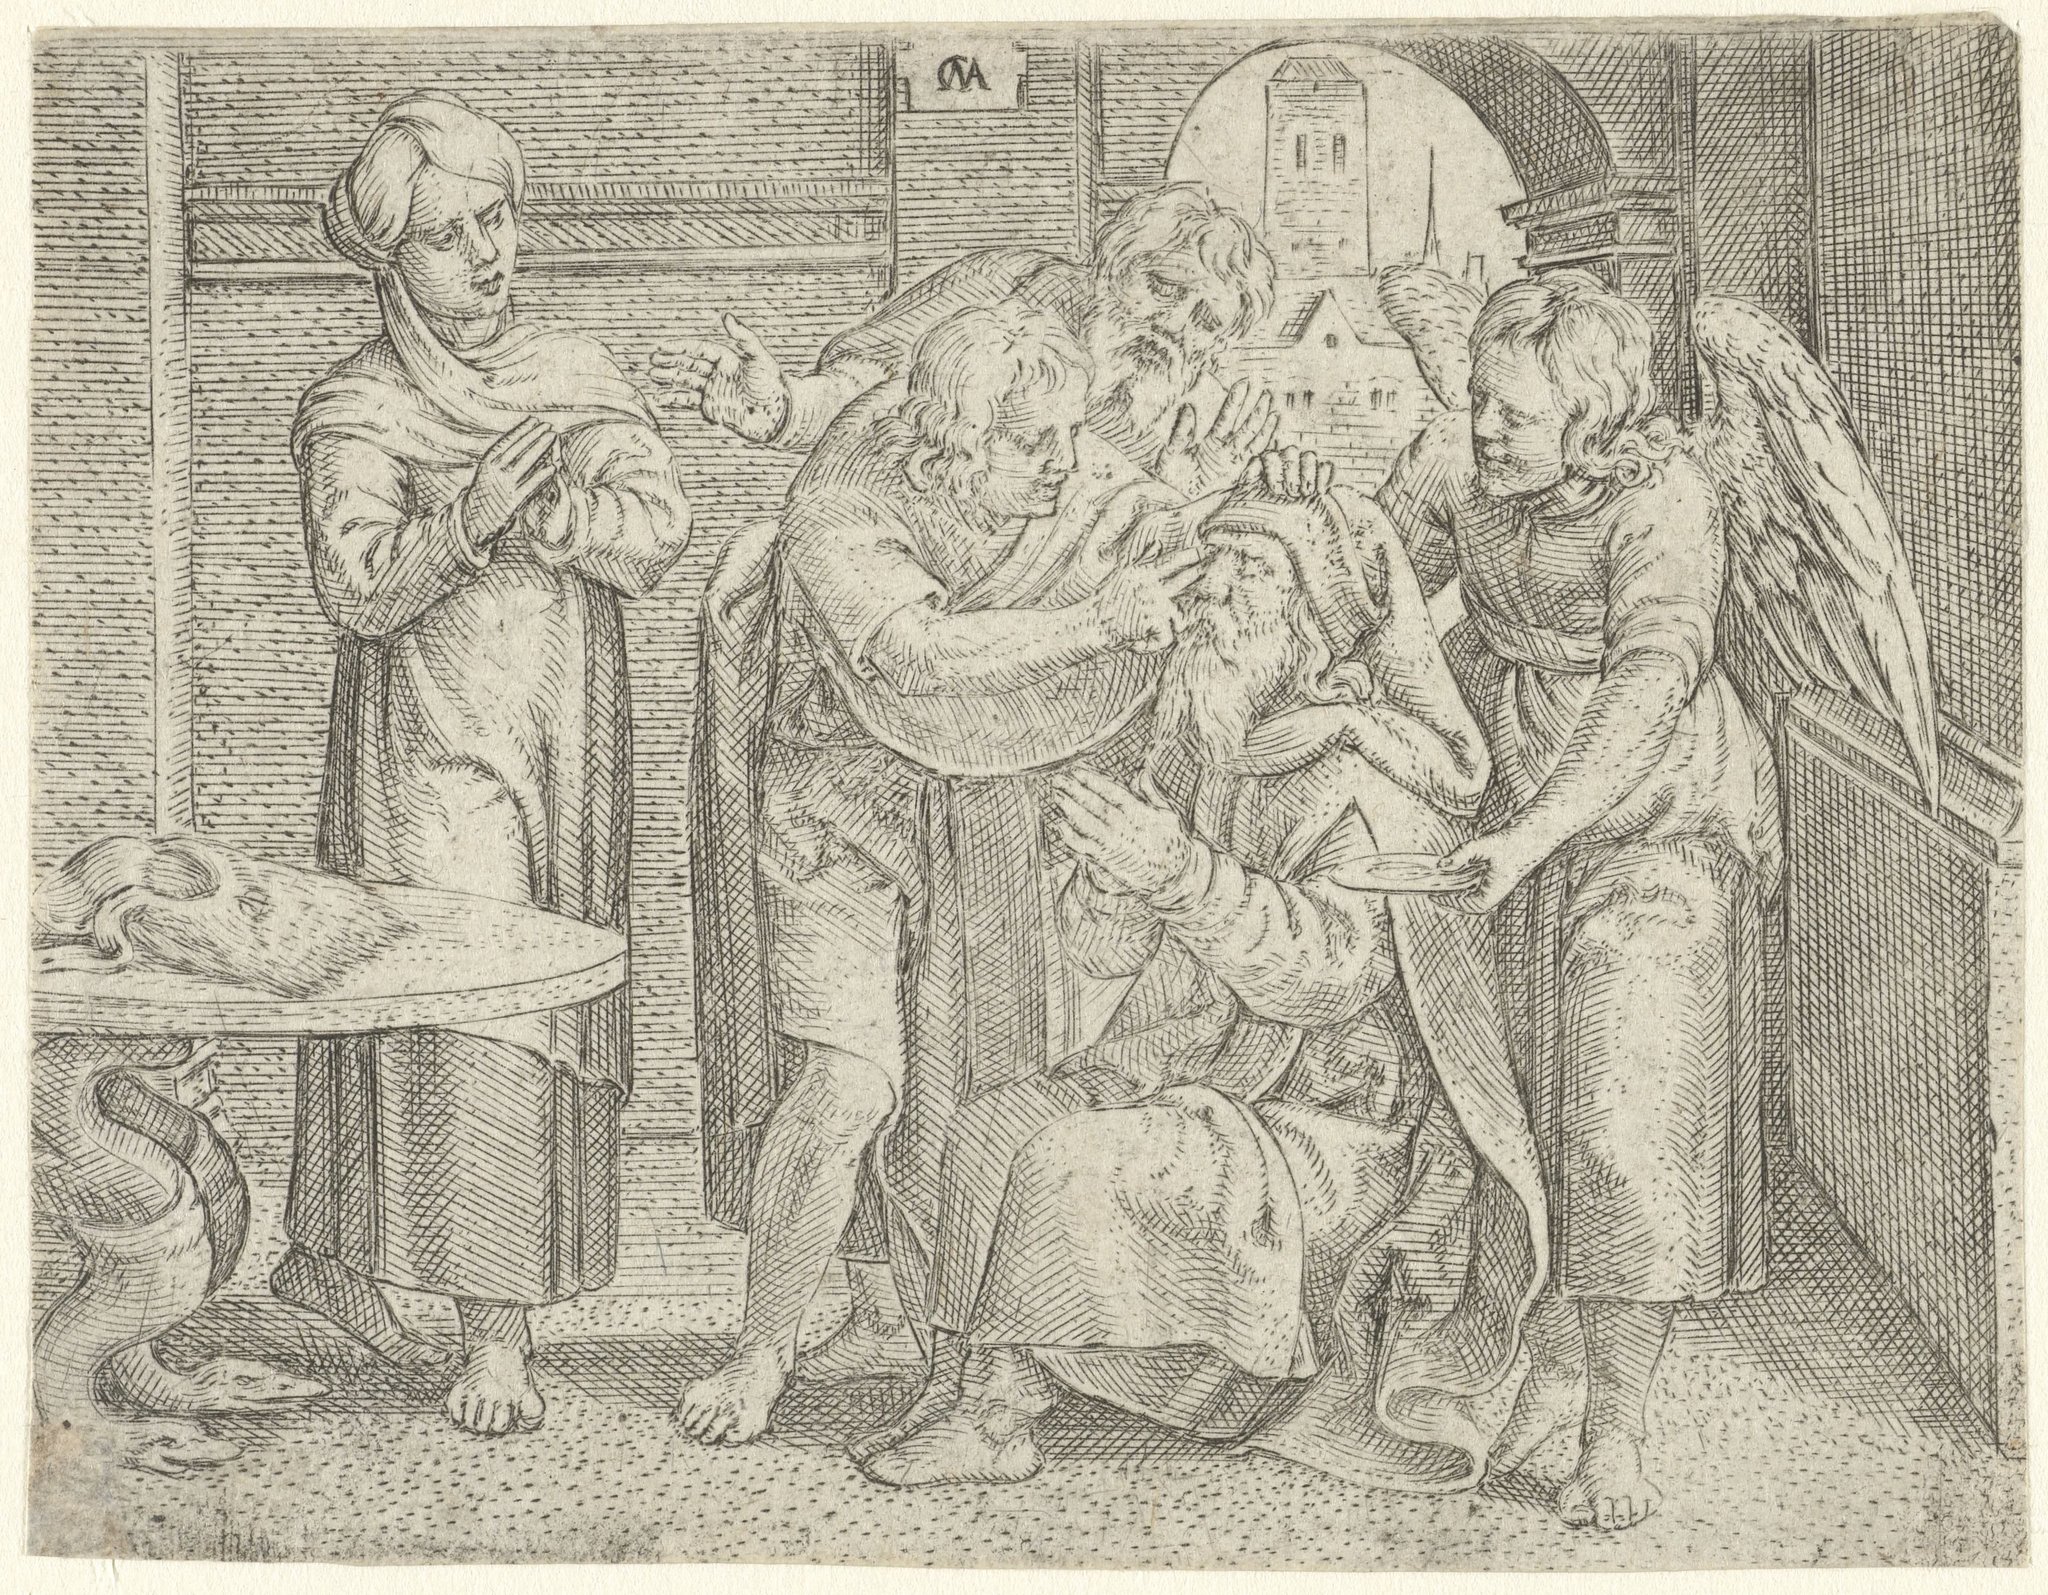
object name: print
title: Genezing van Tobit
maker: cornelis massijs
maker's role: painter, print maker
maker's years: 1510-1557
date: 1544-1556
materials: paper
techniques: engraving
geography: antwerp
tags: the healing of tobit: tobias puts the gall of the fish on his father's eyes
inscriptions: collector's mark: Lugt 2228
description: Bij de thuiskomst van Tobias en de engel legt Tobias de gal van de vis op de ogen van zijn blinde vader Tobit. Daarna kan Tobit weer zien. Anna kijkt links toe.